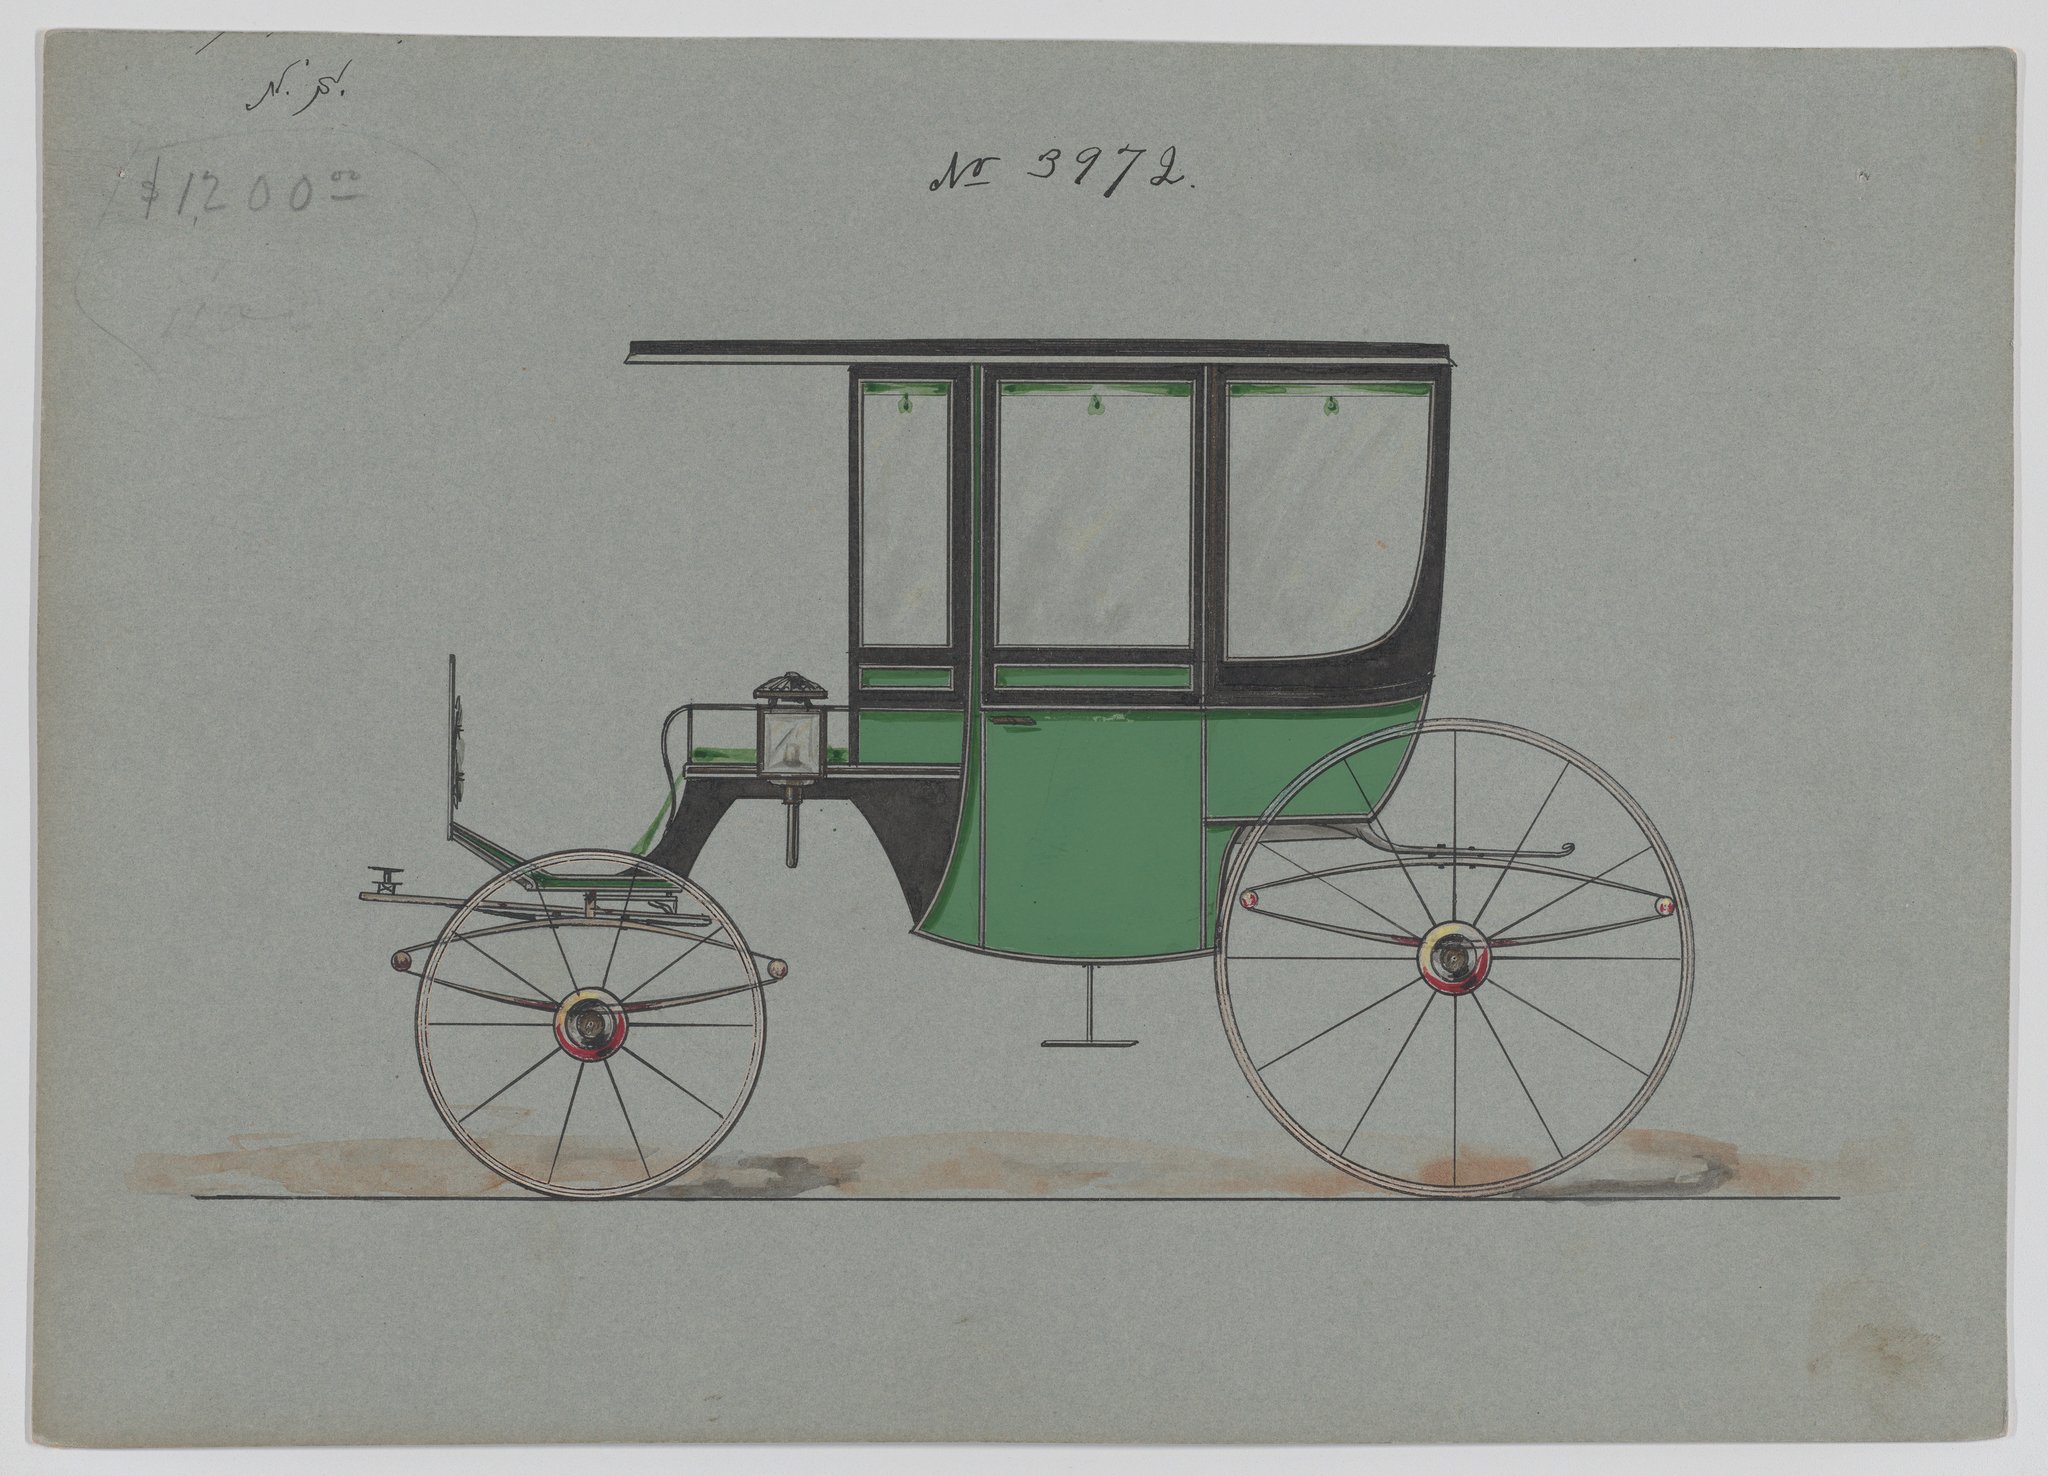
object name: drawing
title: Design for 6 seat Rockaway, no. 3972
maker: brewster & co.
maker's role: manufacturer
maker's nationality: american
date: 1886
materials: gouache, ink, watercolor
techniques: pen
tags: carriages